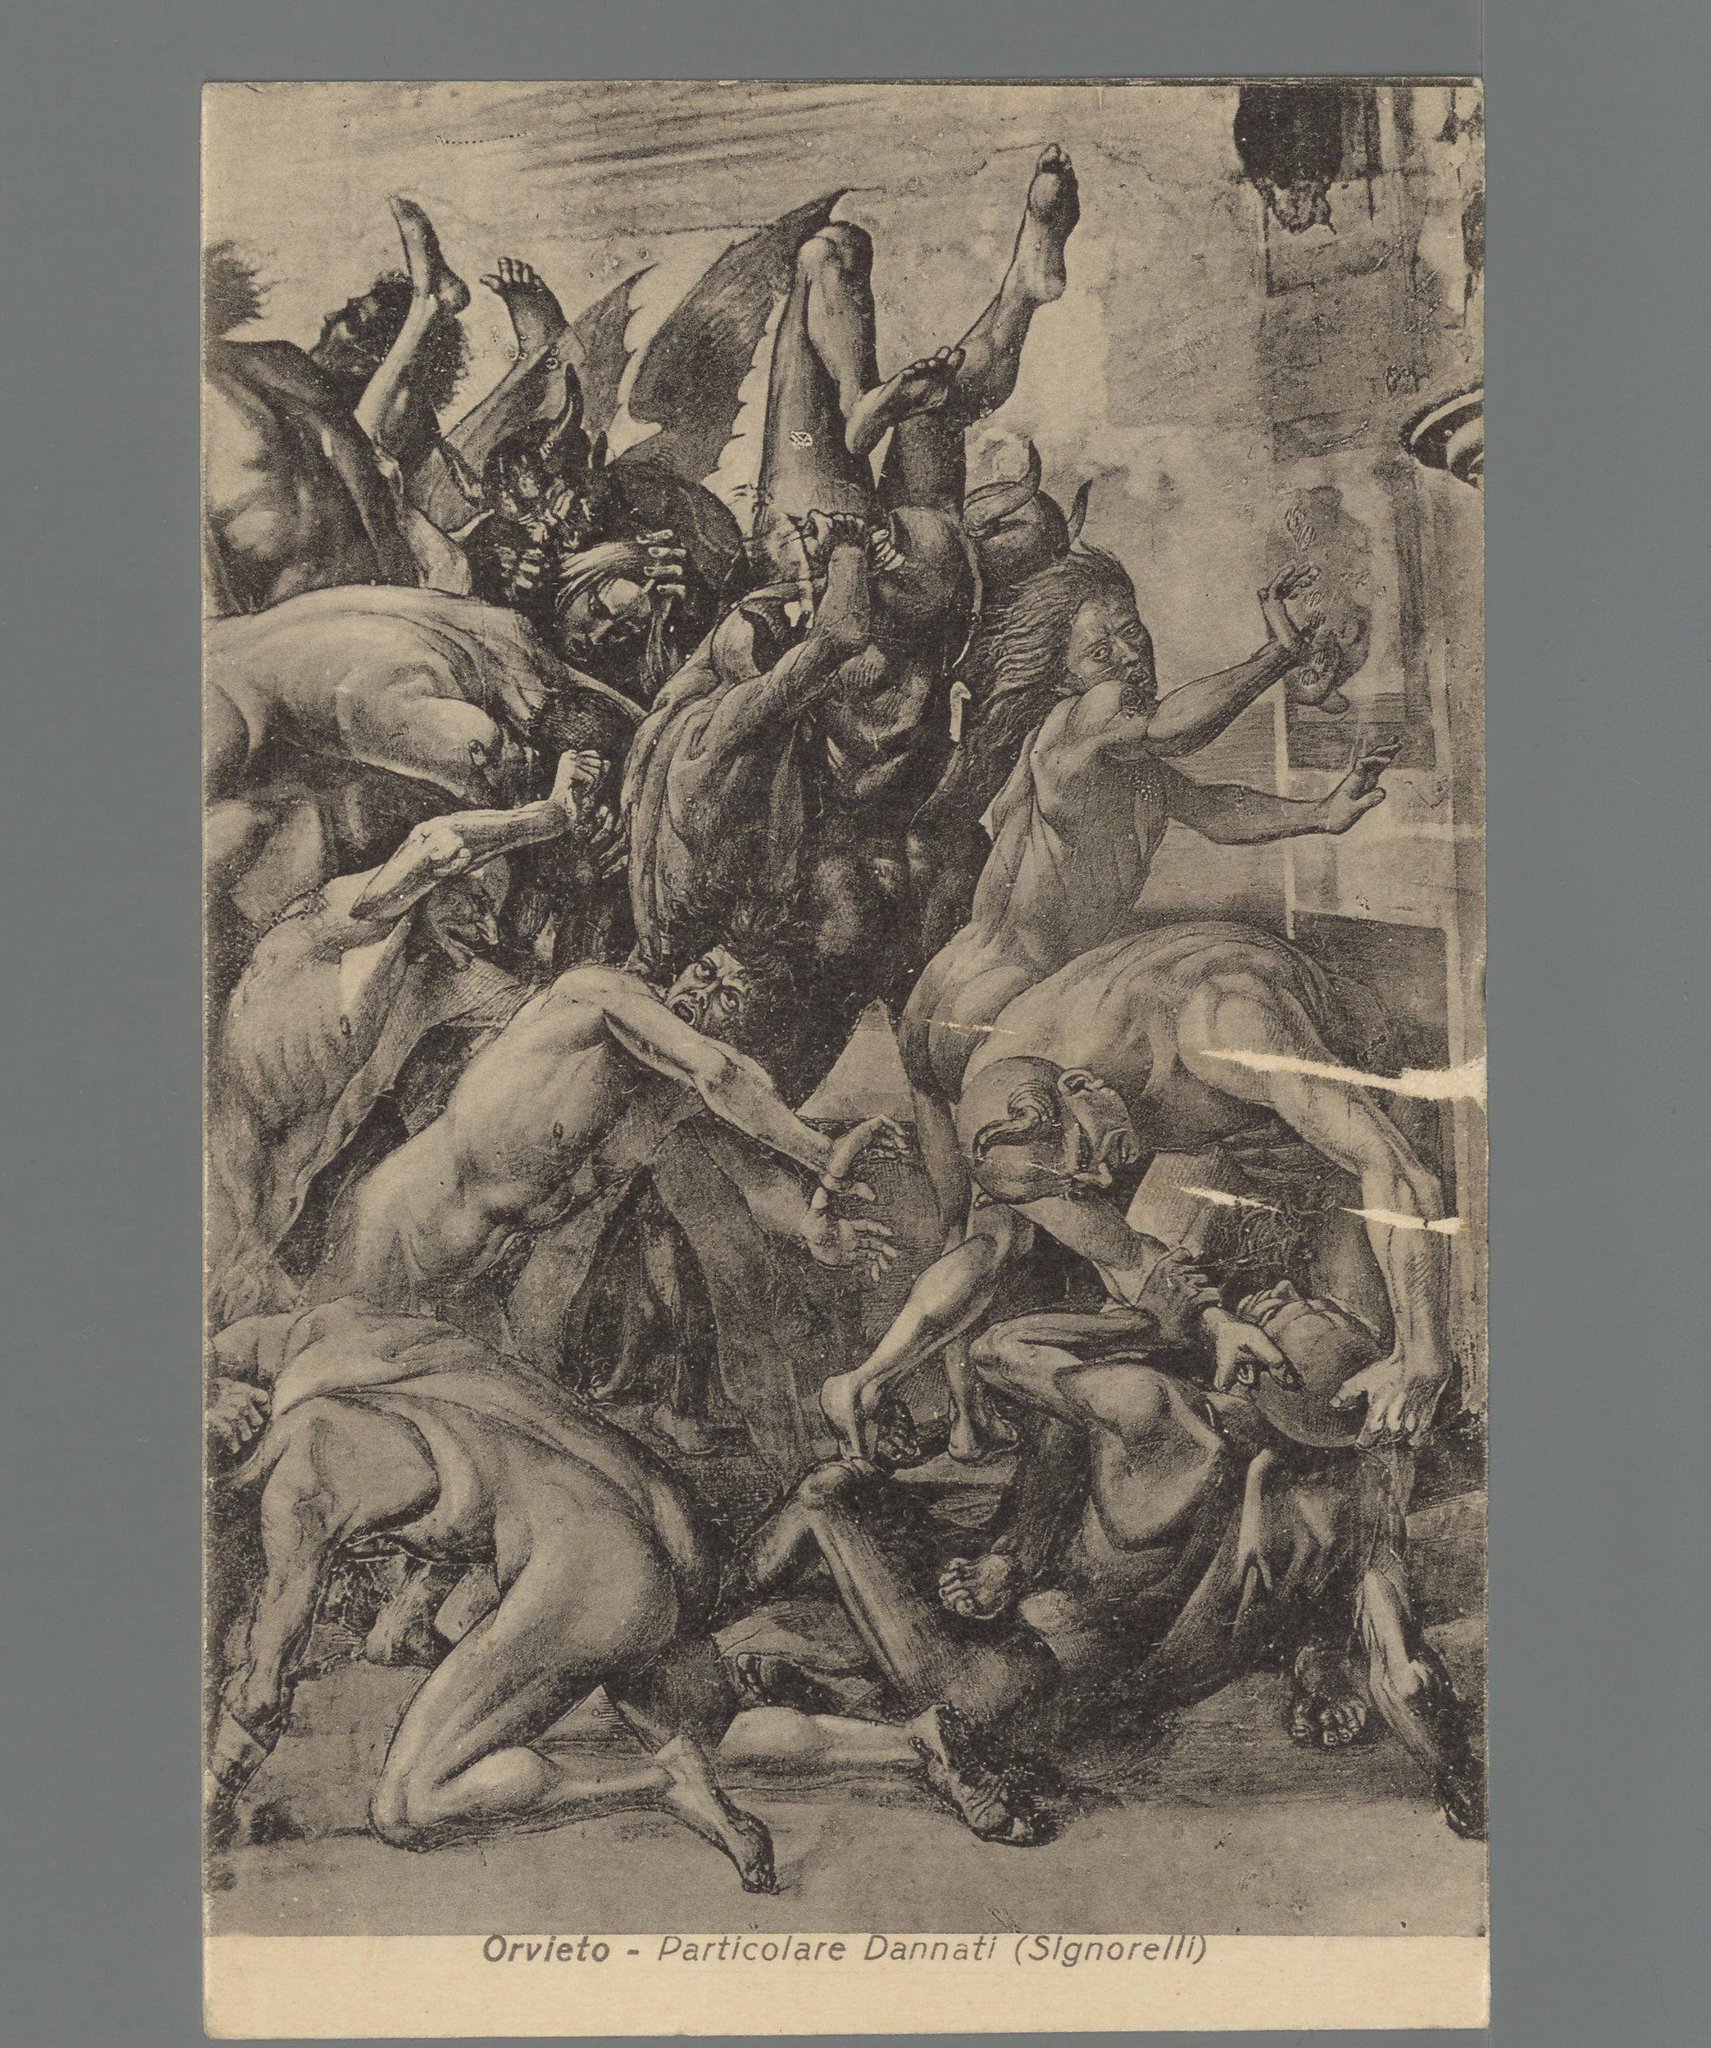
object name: reproduction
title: Orvieto - Particolare Dannati (Signorelli)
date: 1906-1930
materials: cardboard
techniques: photograph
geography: orvieto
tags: permanent exhibition, museum, picture, painting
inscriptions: collector's mark: ‘AFE v S’